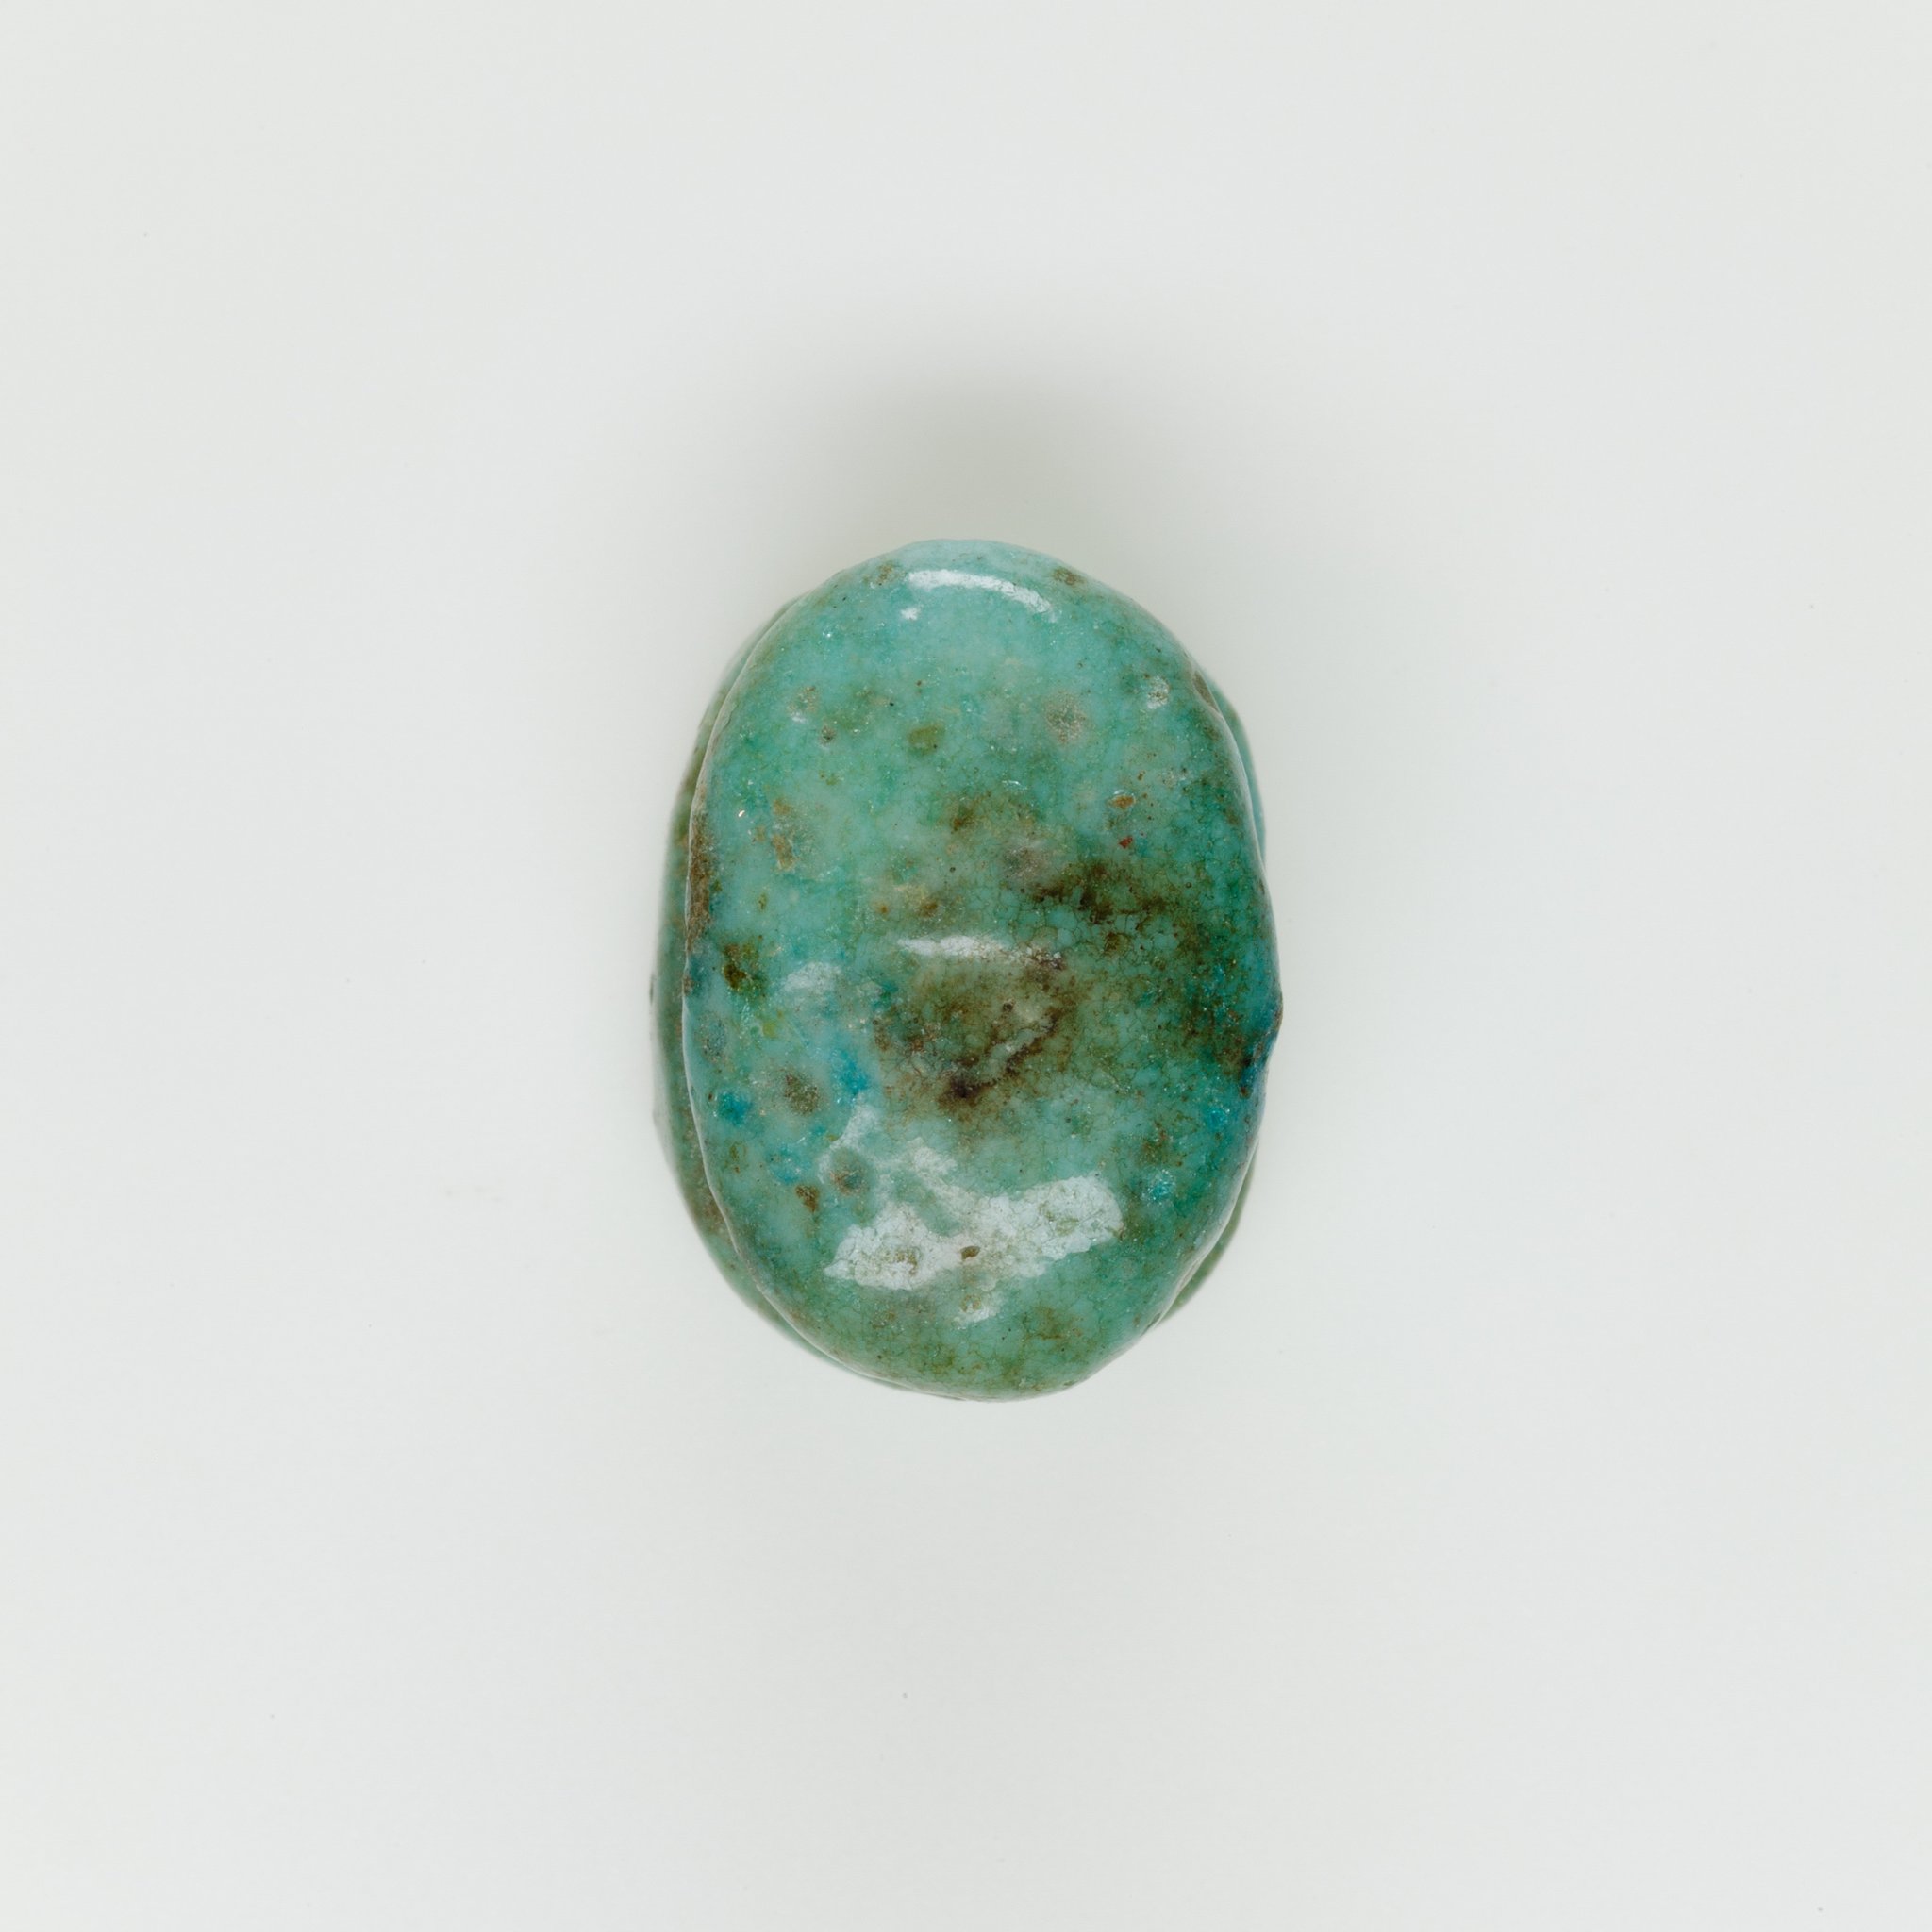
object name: bead, scarab, amenemhat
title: Uninscribed Scaraboid Bead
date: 1504-1447 BCE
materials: faience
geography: egypt